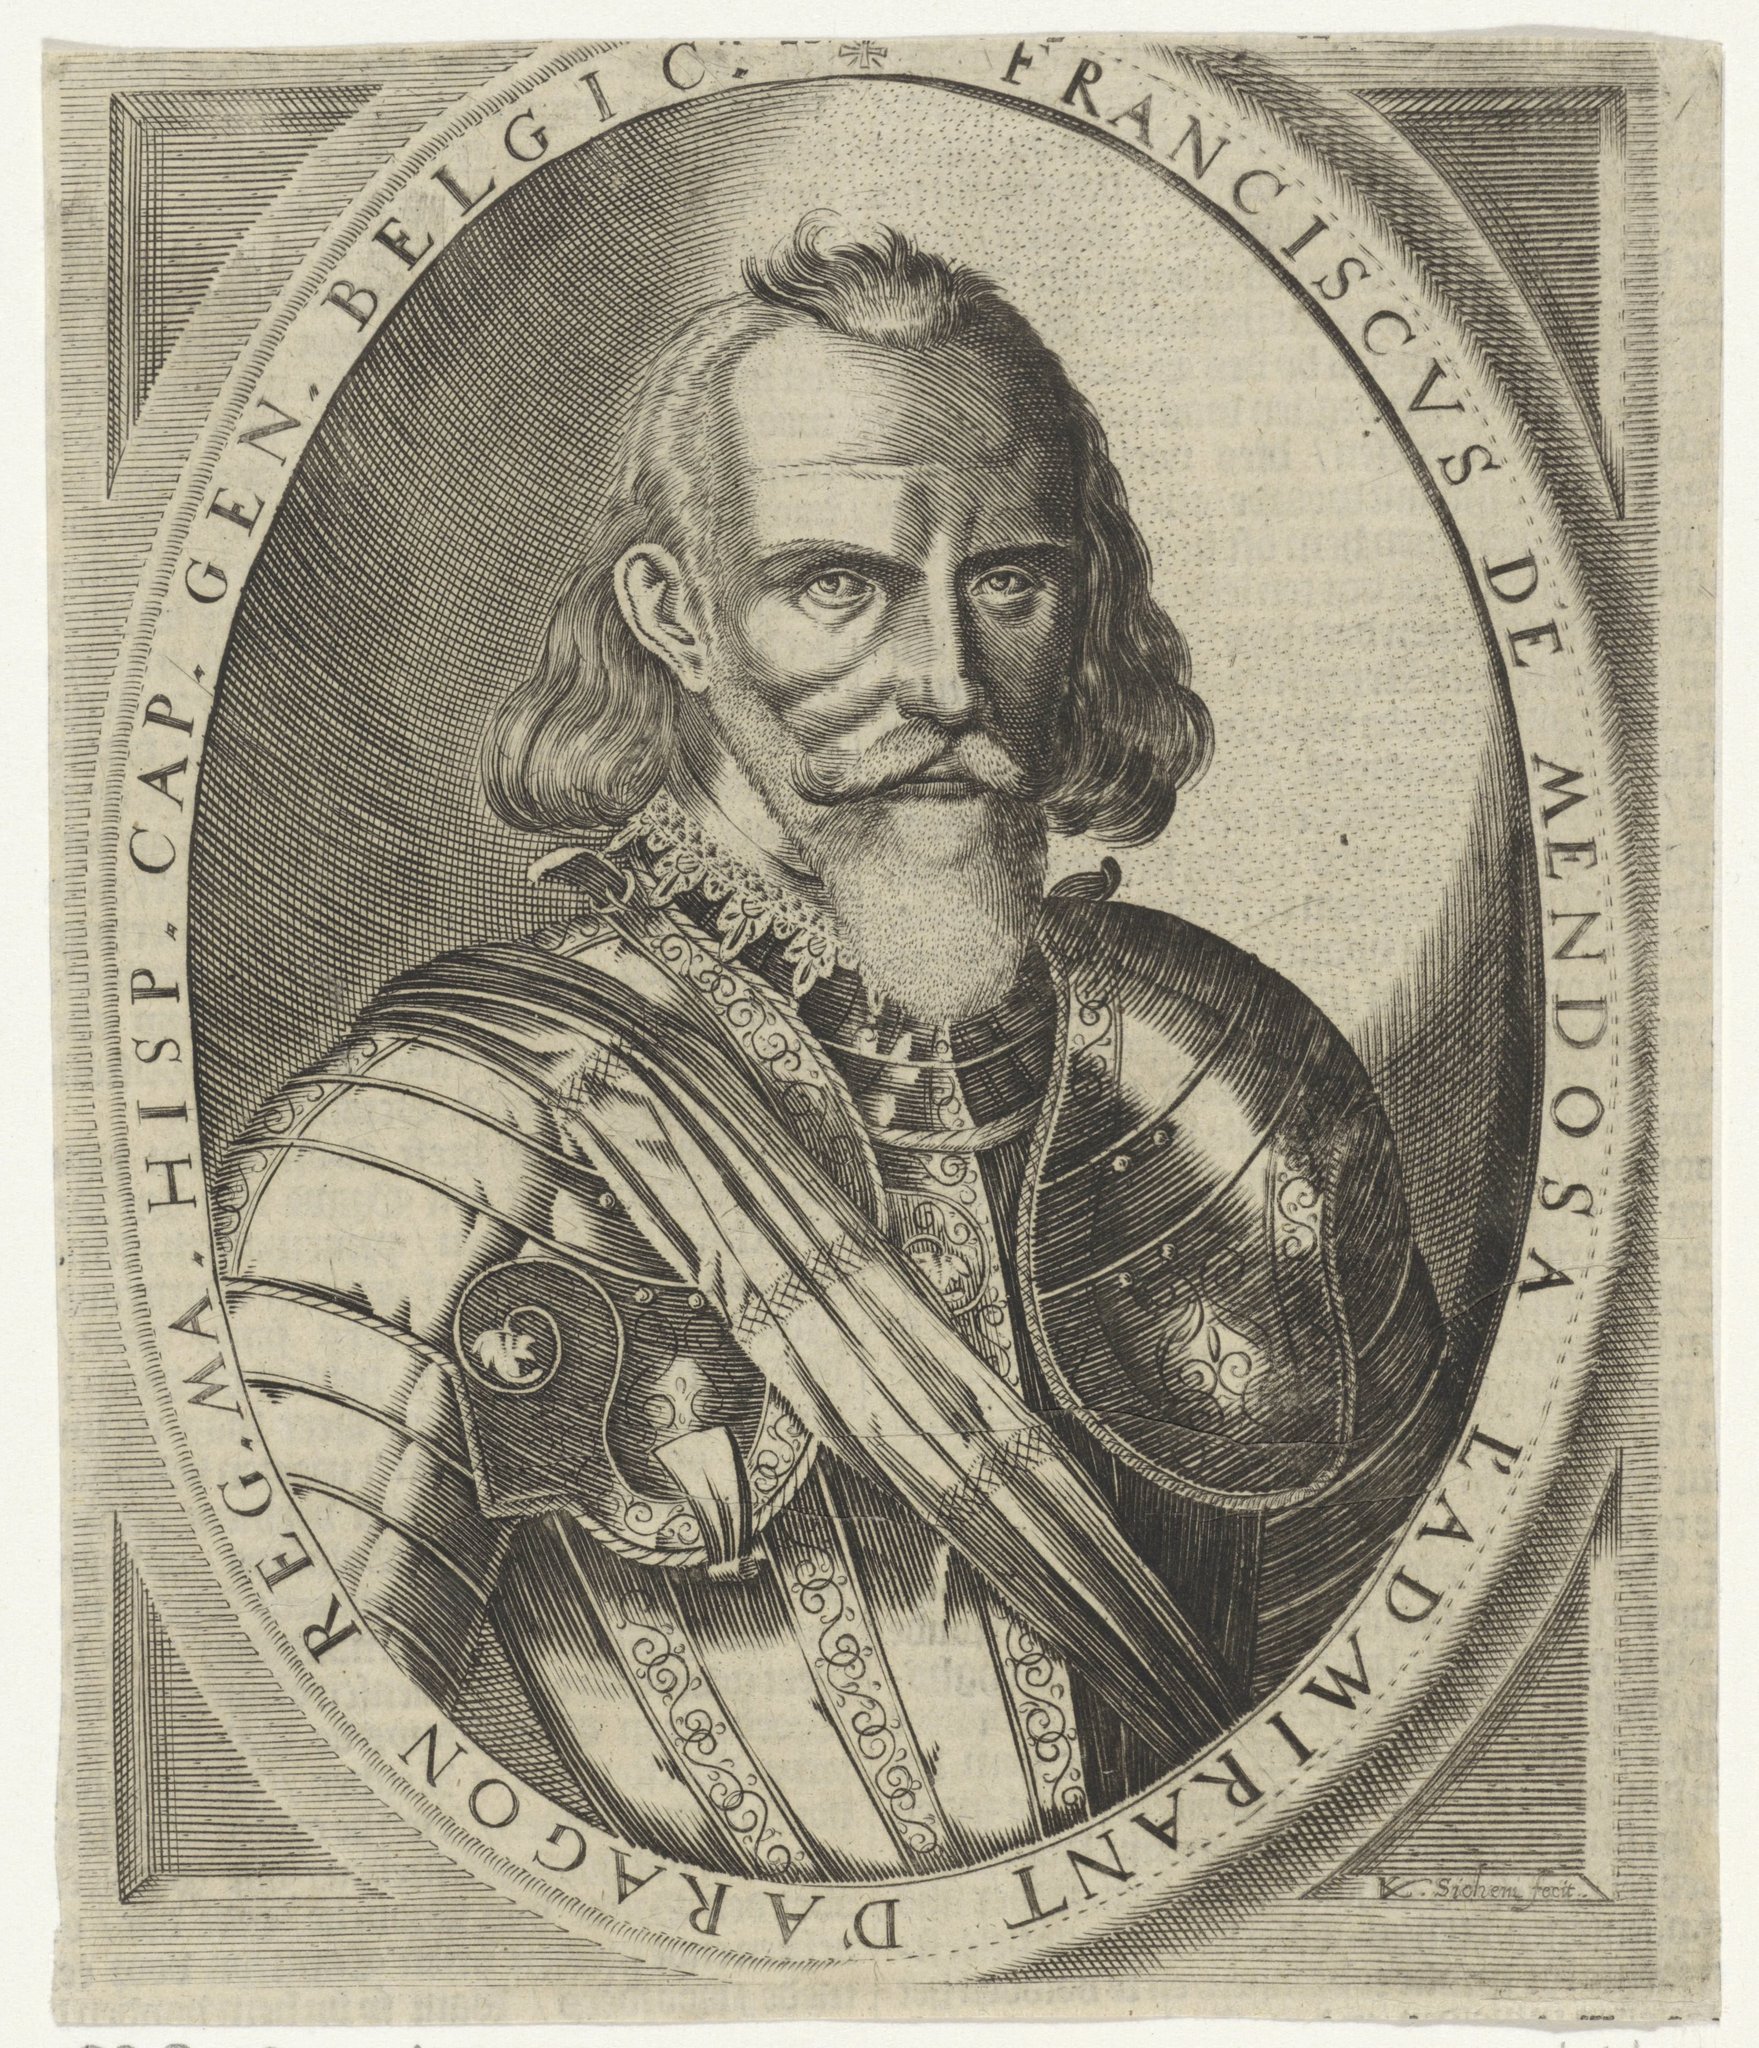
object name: print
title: Portret van Francisco Hurtado de Mendoza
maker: karel van sichem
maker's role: print maker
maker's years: 1575-1604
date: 1626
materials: paper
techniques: engraving, letterpress printing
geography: amsterdam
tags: admiraal, francisco hurtado de mendoza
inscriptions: collector's mark: Lugt 2228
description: De tekst in boekdruk op de verso-zijde van deze prent is een andere dan die uit de edities 1647 en 1663 van: E. van Meteren. Historien der Nederlanden, waarin deze prent in deze staat ook voorkomt.